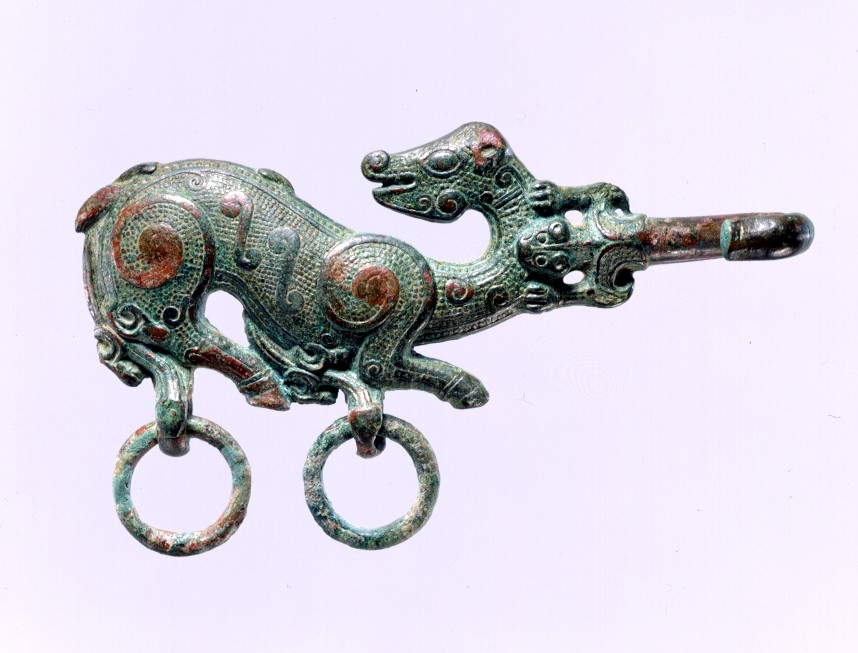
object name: belt hook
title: Belt Hook in the Shape of an Ungulate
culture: northwest chinese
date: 500-401 BCE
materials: bronze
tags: animals